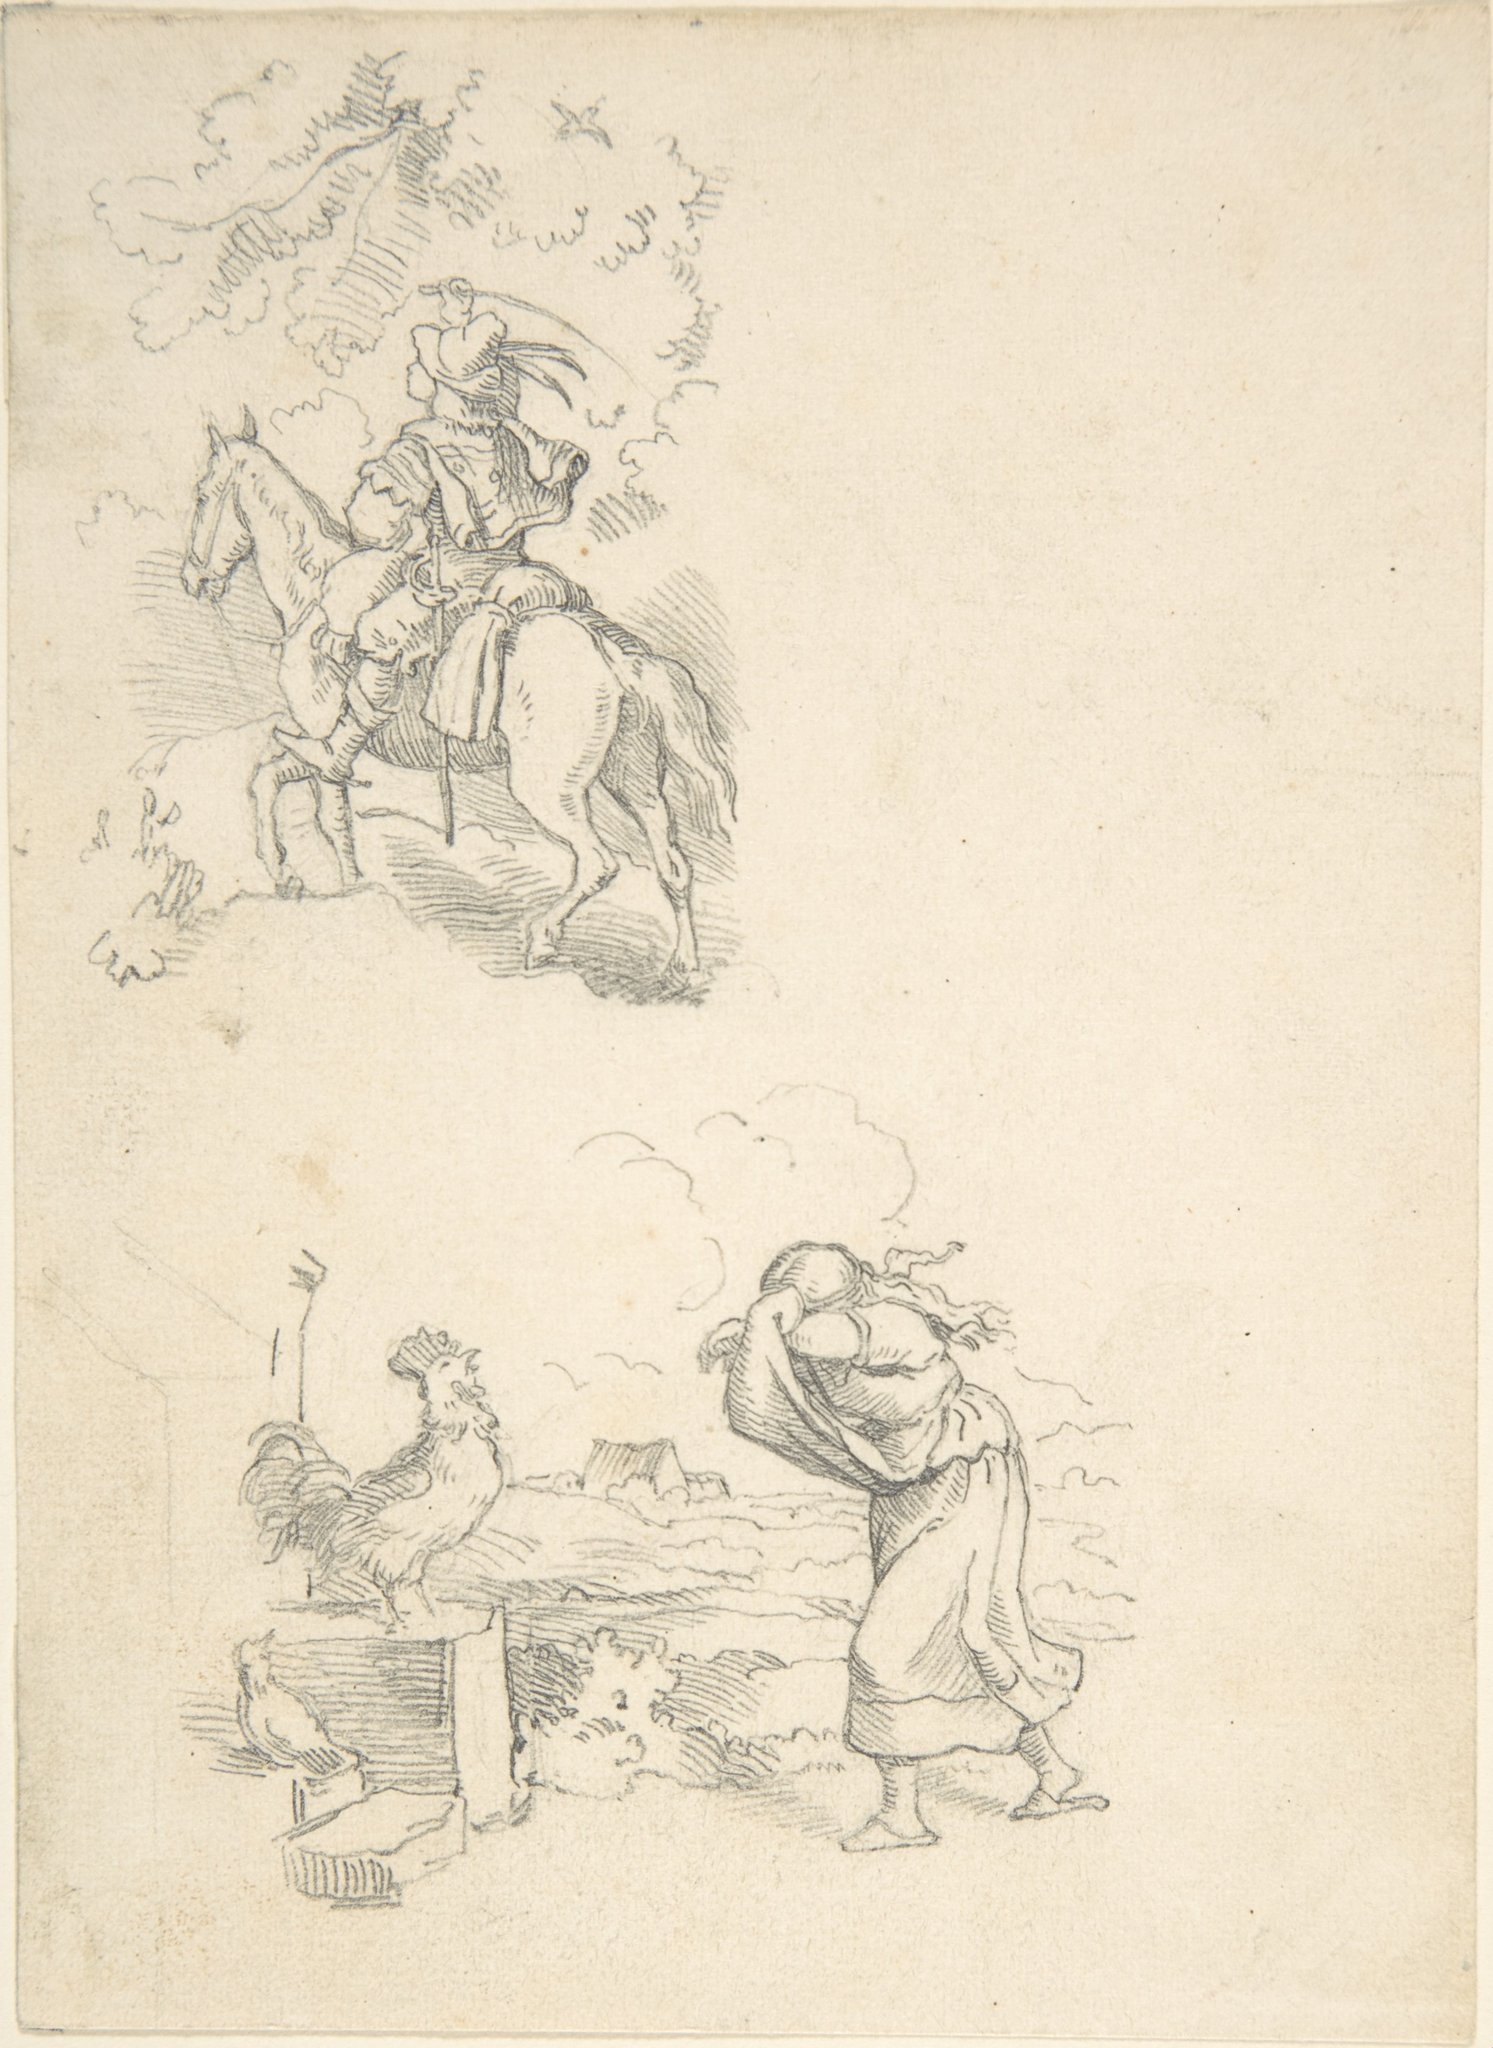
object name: drawing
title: Two Designs for Illustration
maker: adrian ludwig richter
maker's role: artist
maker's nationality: german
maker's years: 1803-1884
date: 1820-1884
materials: graphite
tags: men,women,roosters,horses